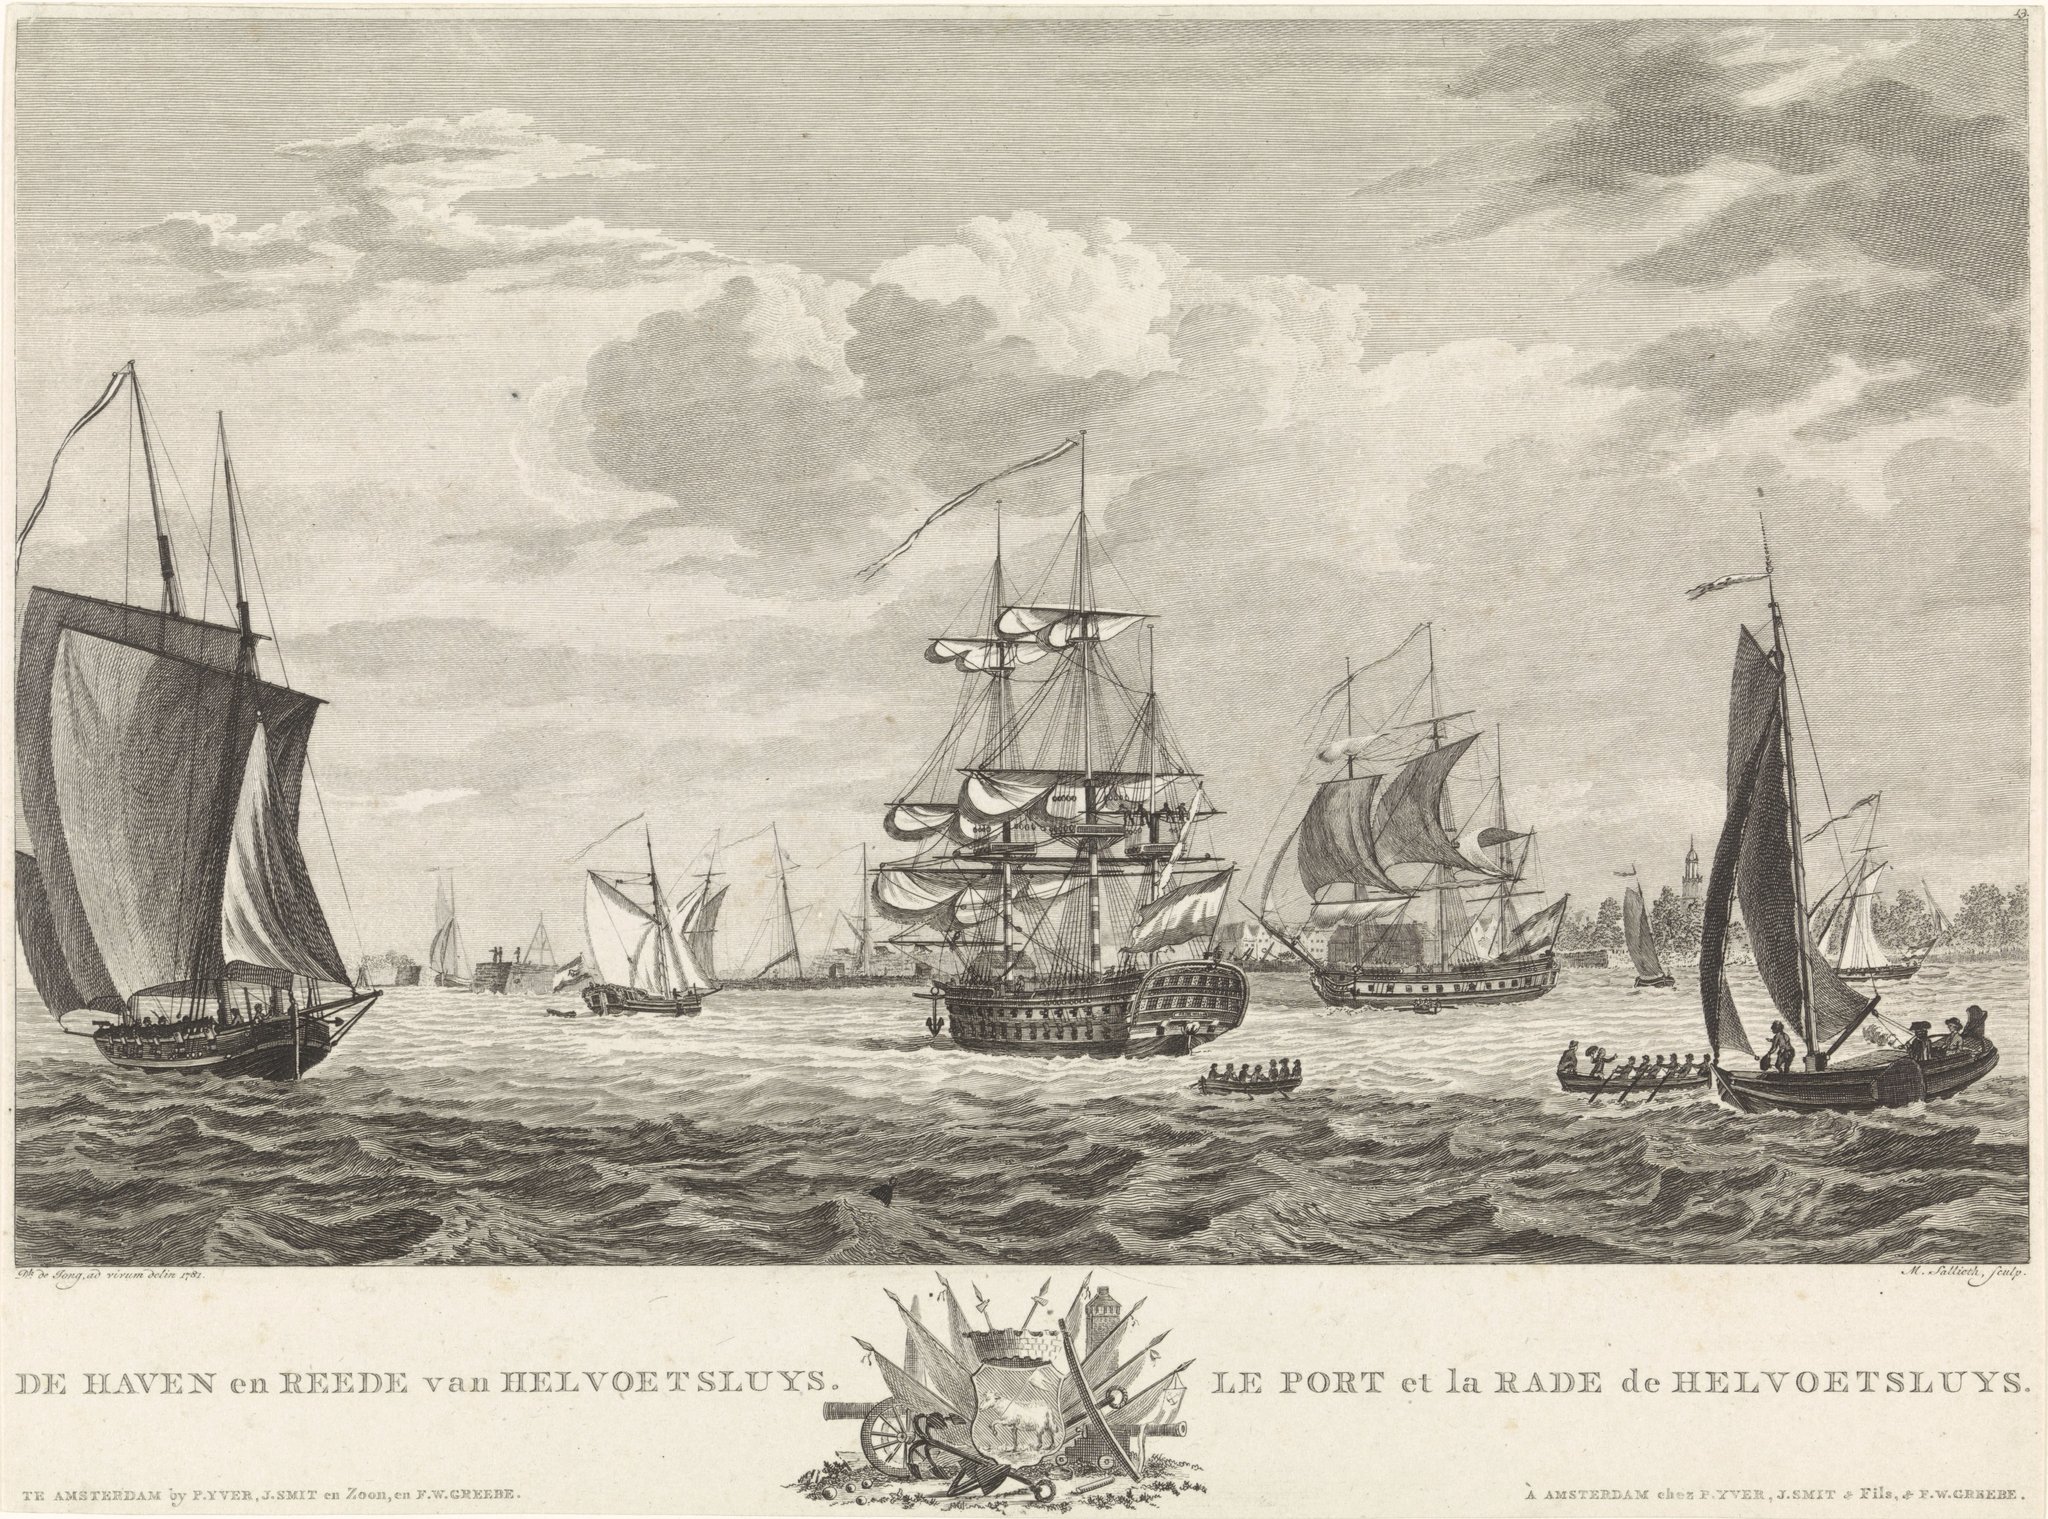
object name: print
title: Haven en rede van Hellevoetsluis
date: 1781-1787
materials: paper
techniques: etching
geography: amsterdam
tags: harbour, coat of arms (as symbol of the state, etc.) (+ city; municipal), sailing-ship, sailing-boat, ship in the roads, roadstead, hellevoetsluis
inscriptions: collector's mark: Lugt 2228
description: Latere staat ook gebruikt in: Aa, Cornelis van der. Atlas van de zeehavens der Bataafsche Republiek. Met derzelver beschrijvingen in XXXI kunstplaaten / Atlas van de zeehavens der Bataafsche Republiek, die van Batavia en Onrust. Mitsgaders de afbeeldingen van de haringvisscherij en de walvischvangst […]. Amsterdam: Evert Maaskamp, 1805.